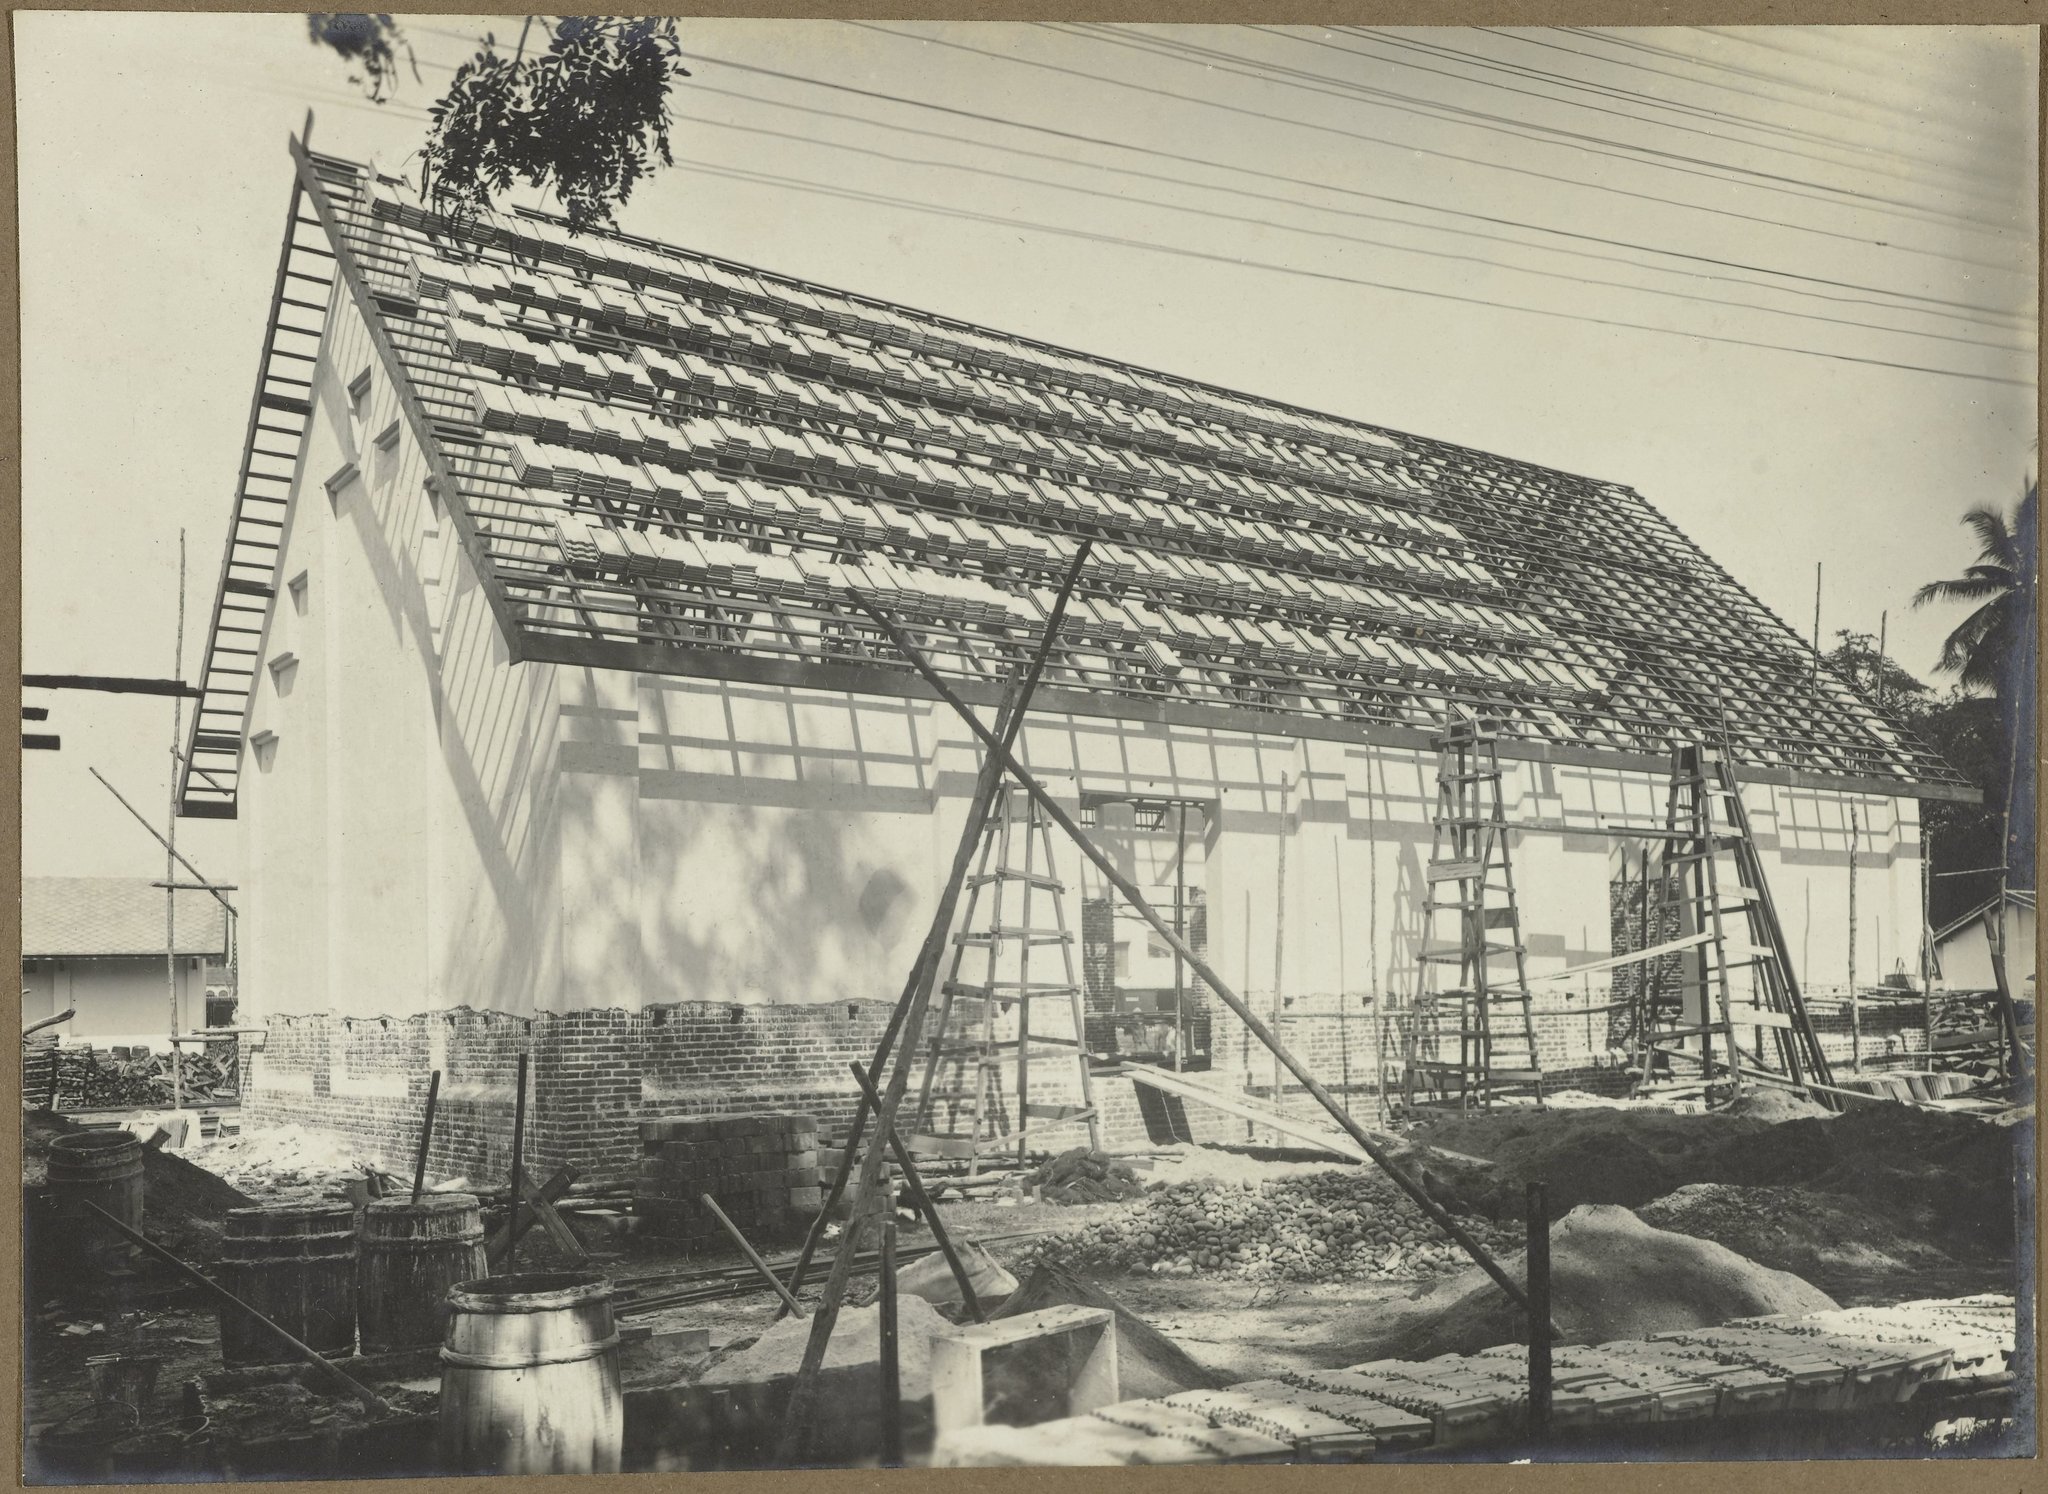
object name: photograph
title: Pand langs het spoor in aanbouw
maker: Anonymous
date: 1914-1919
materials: photographic support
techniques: gelatin silver print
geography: medan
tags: making the overground structures (~ building activities), railway, train, representation of real building (either existing or having existed), architecture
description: Het bedrijfspand langs aan het spoor in aanbouw, waarschijnlijk te Medan. Foto in het fotoalbum van het Nederlandse architectenbureau en aannemersbedrijf Bennink en Riphagen te Medan in de jaren ca. 1914-1919.